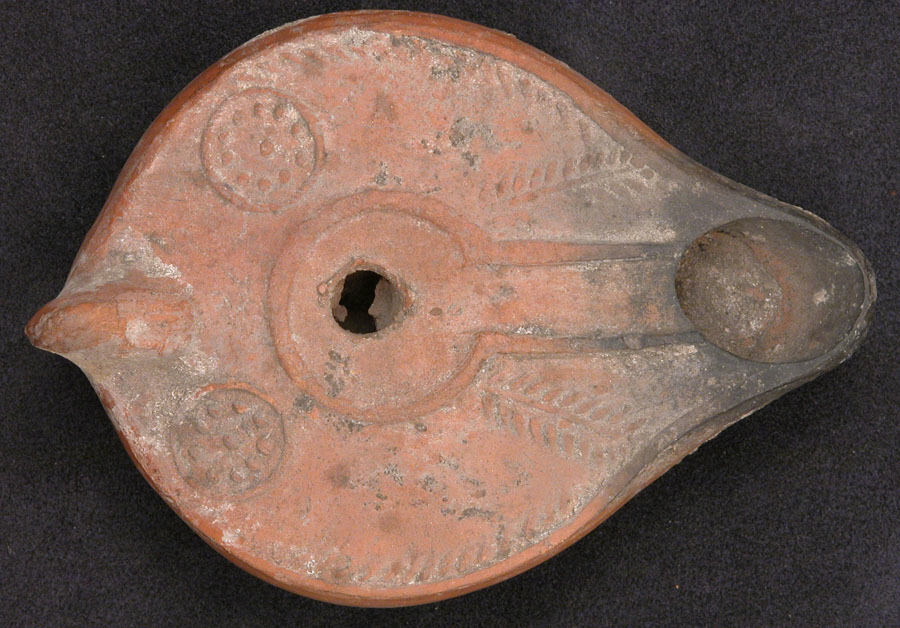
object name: lamp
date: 301-400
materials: earthenware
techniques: molding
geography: egypt